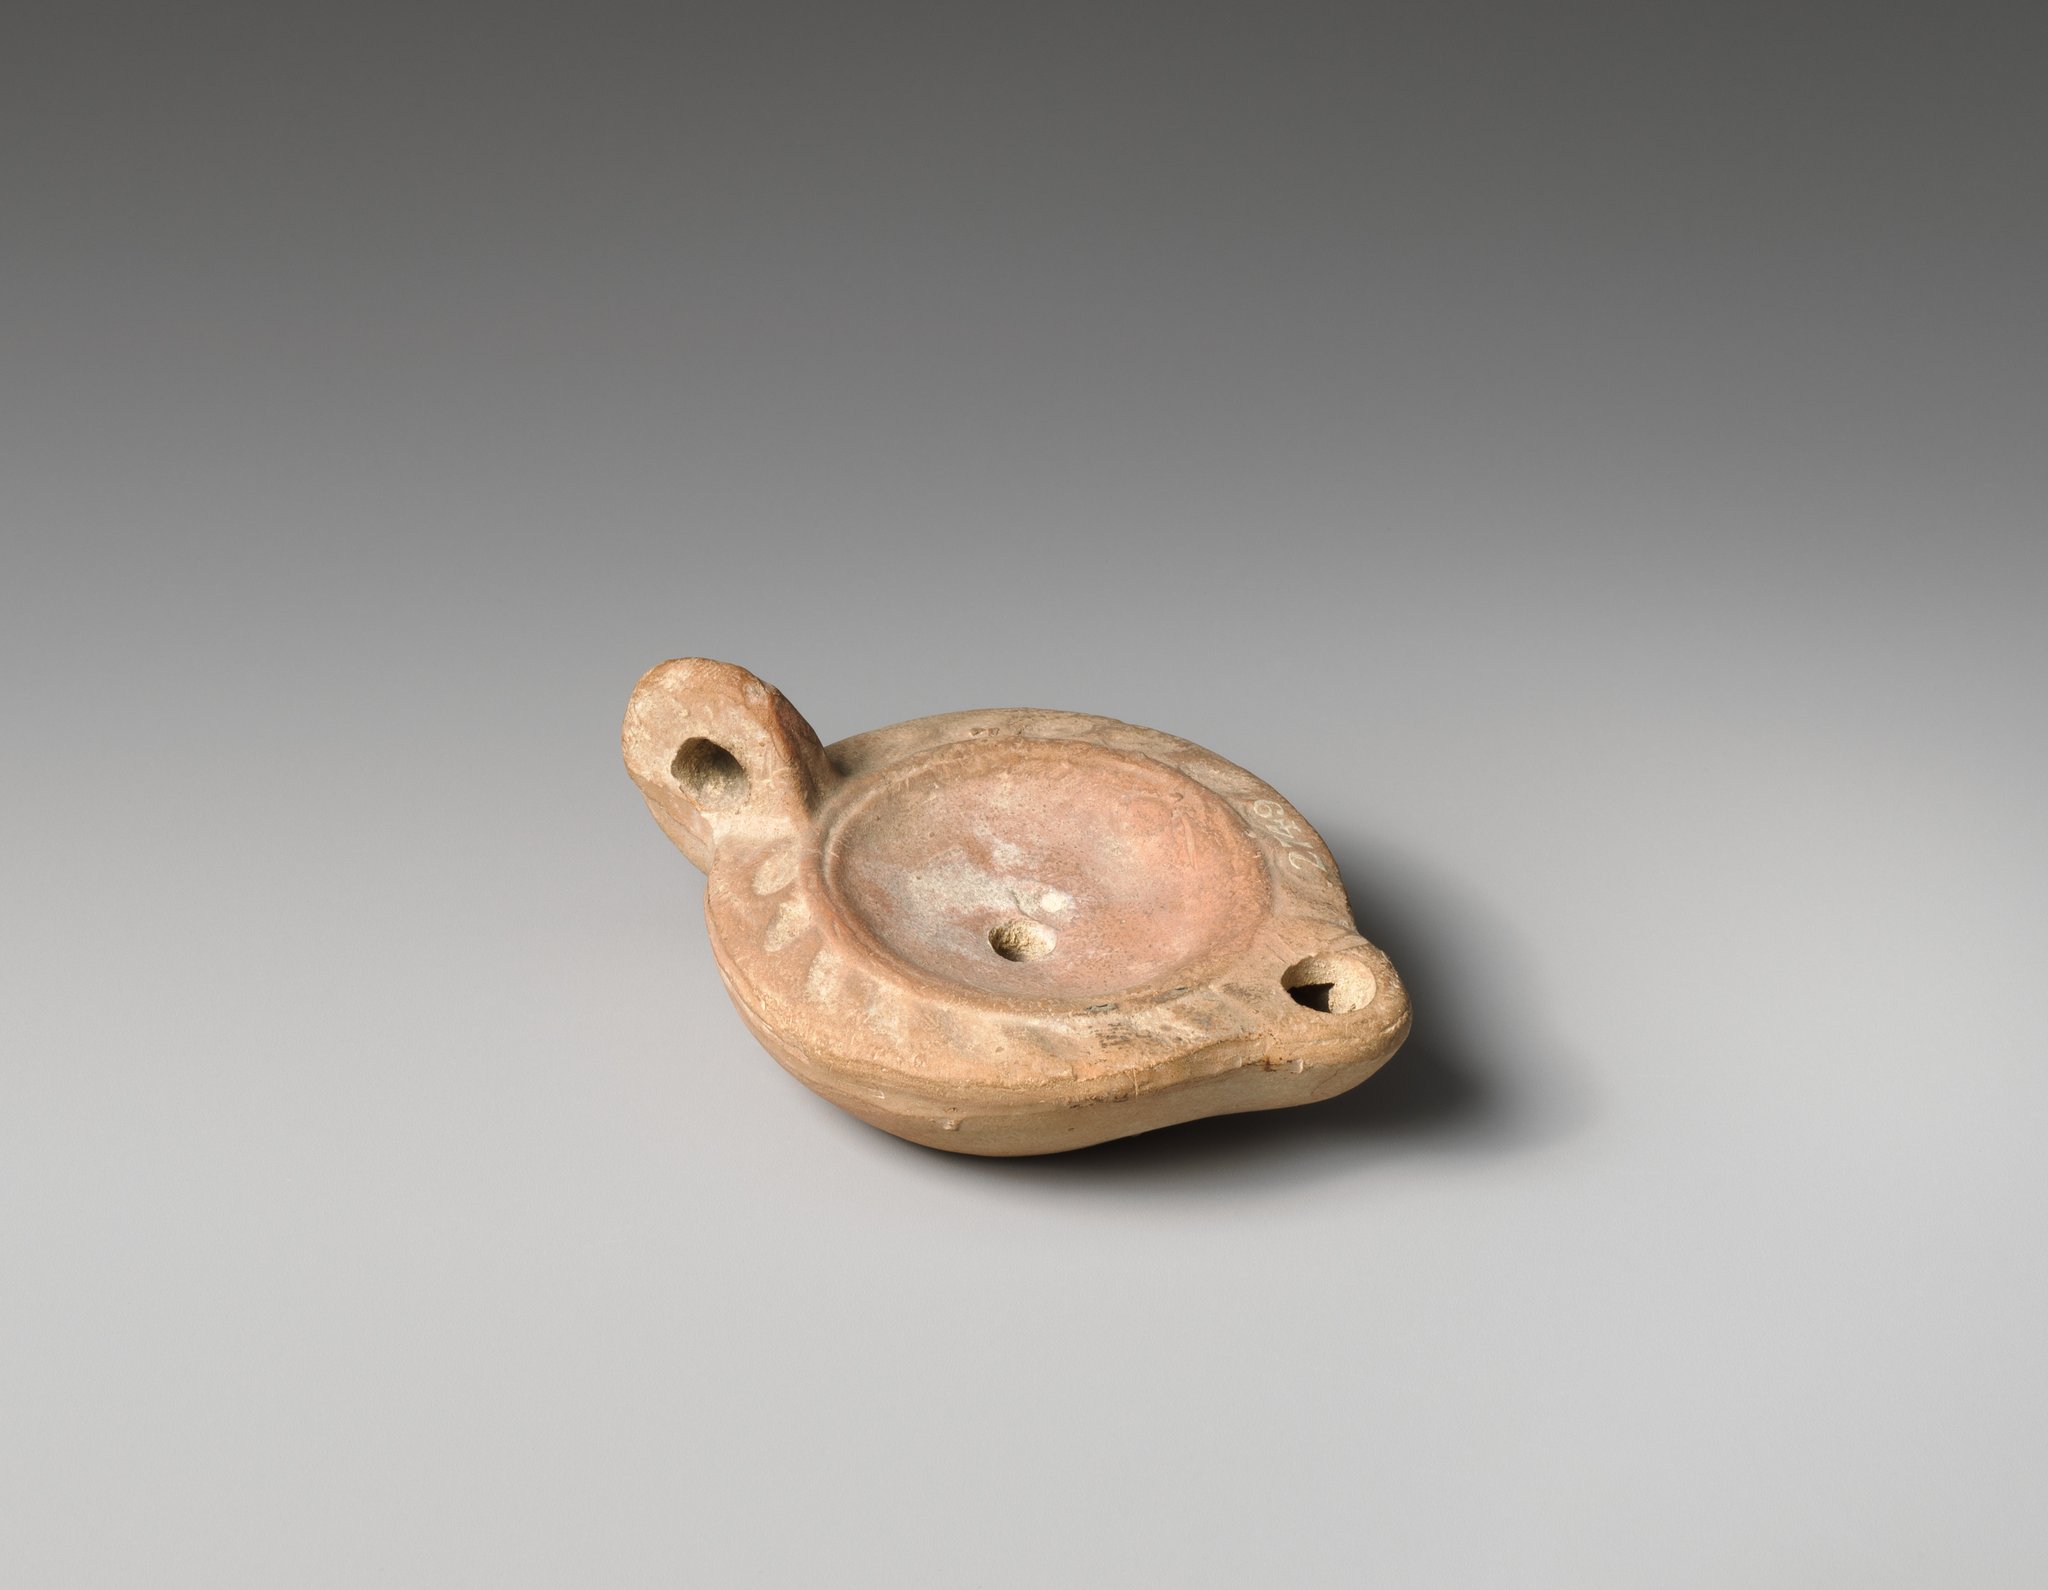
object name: lamp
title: Terracotta oil lamp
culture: roman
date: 101-200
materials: terracotta